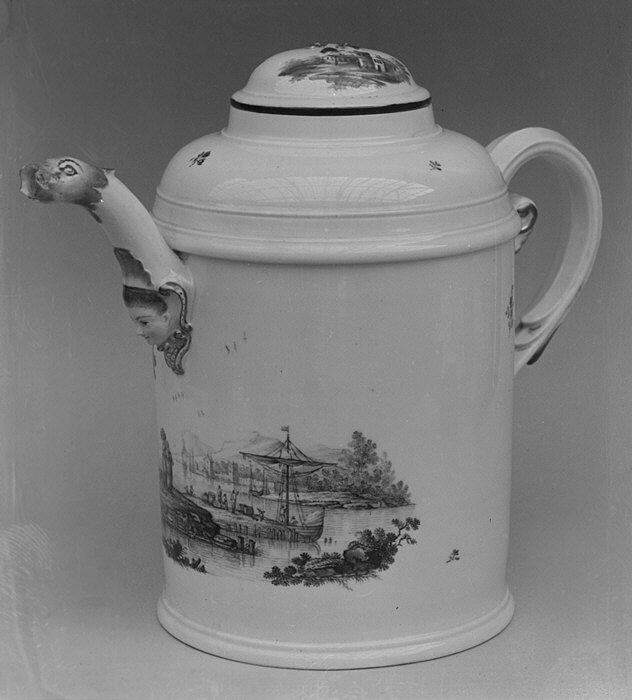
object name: coffeepot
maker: ansbach pottery and porcelain manufactory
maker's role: manufactory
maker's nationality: german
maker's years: 1758-1860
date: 1780-1790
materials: hard paste porcelain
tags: landscapes,ships